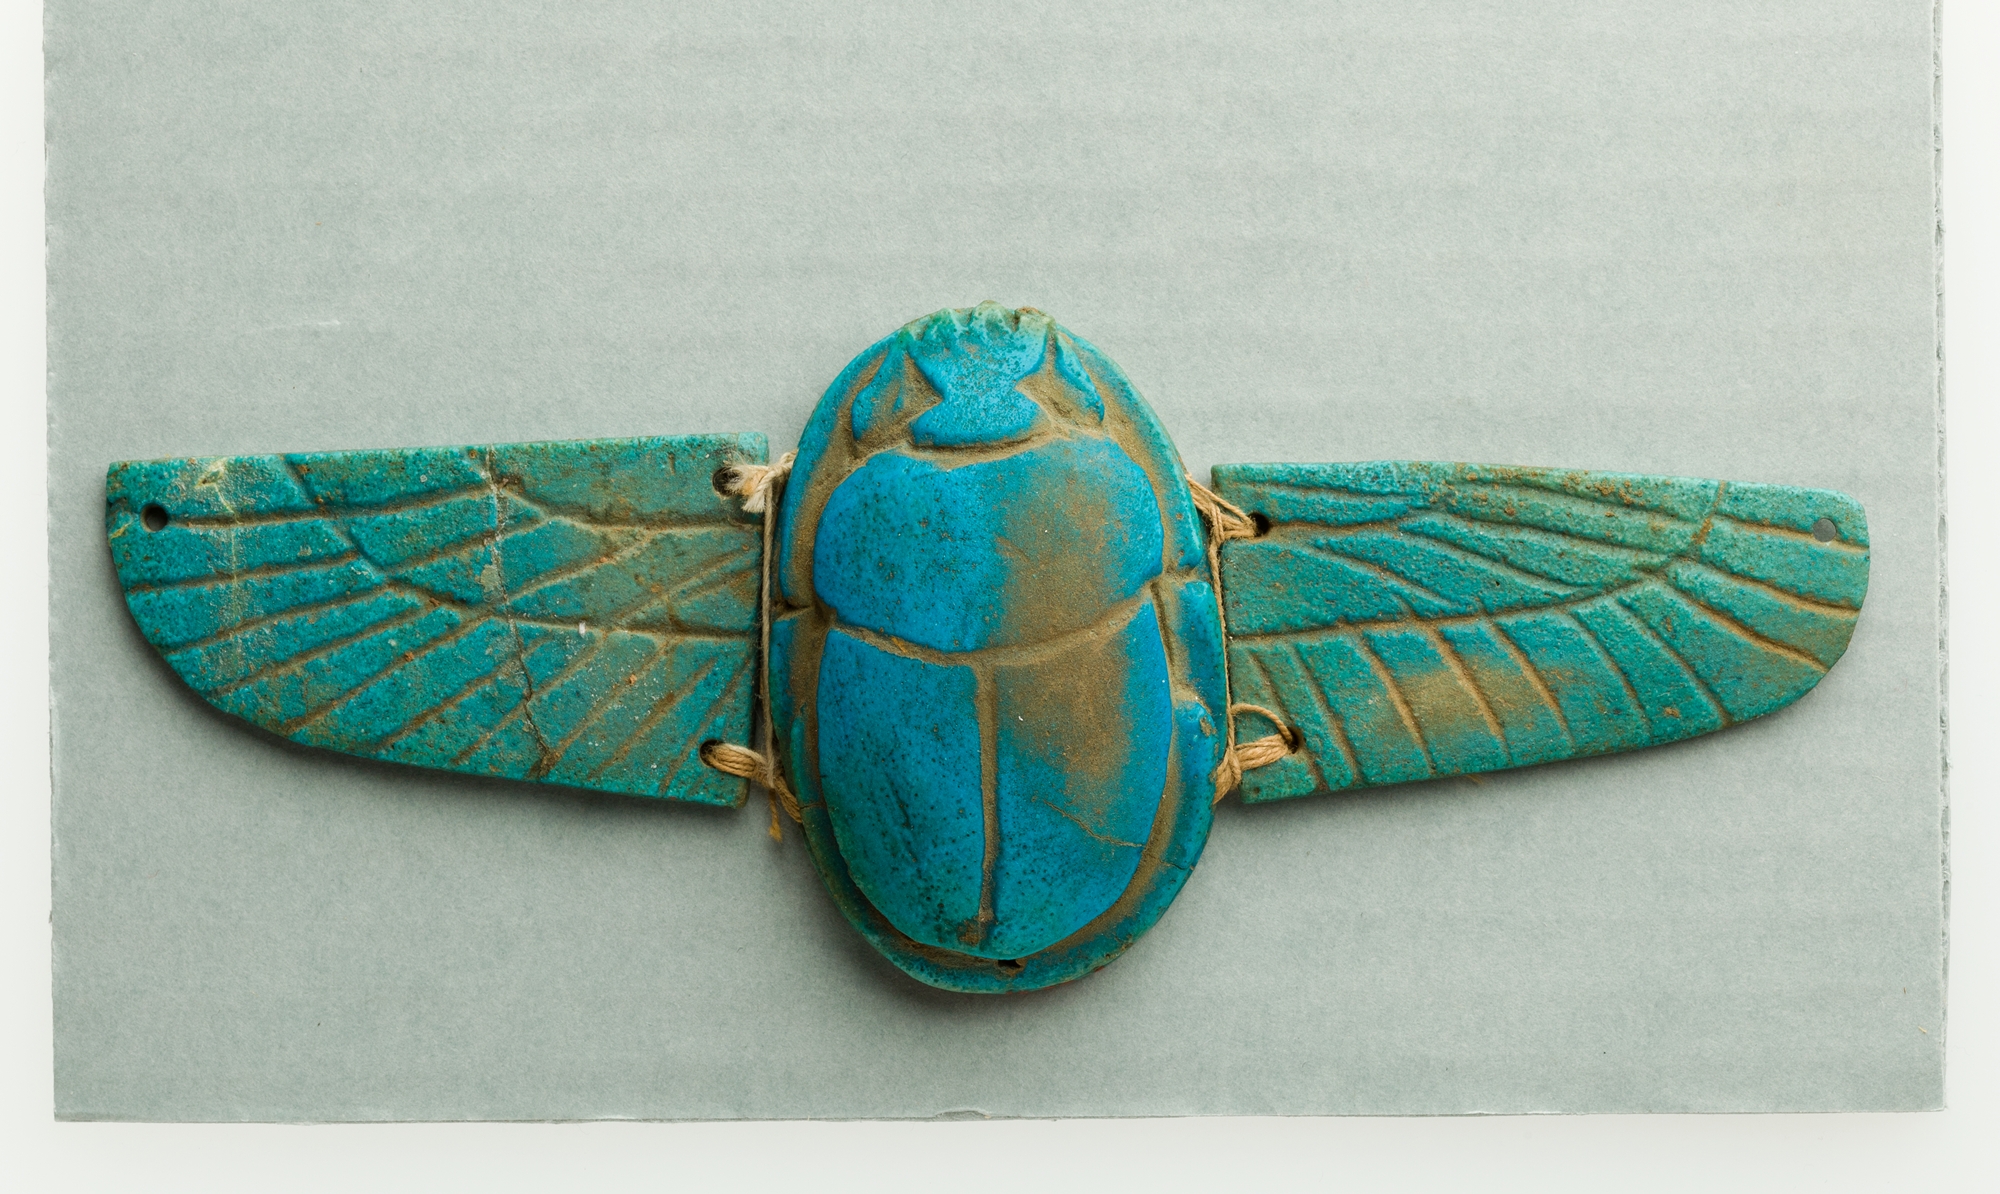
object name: amulet, winged scarab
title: Winged Scarab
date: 664-332 BCE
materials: faience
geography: egypt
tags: scarabs